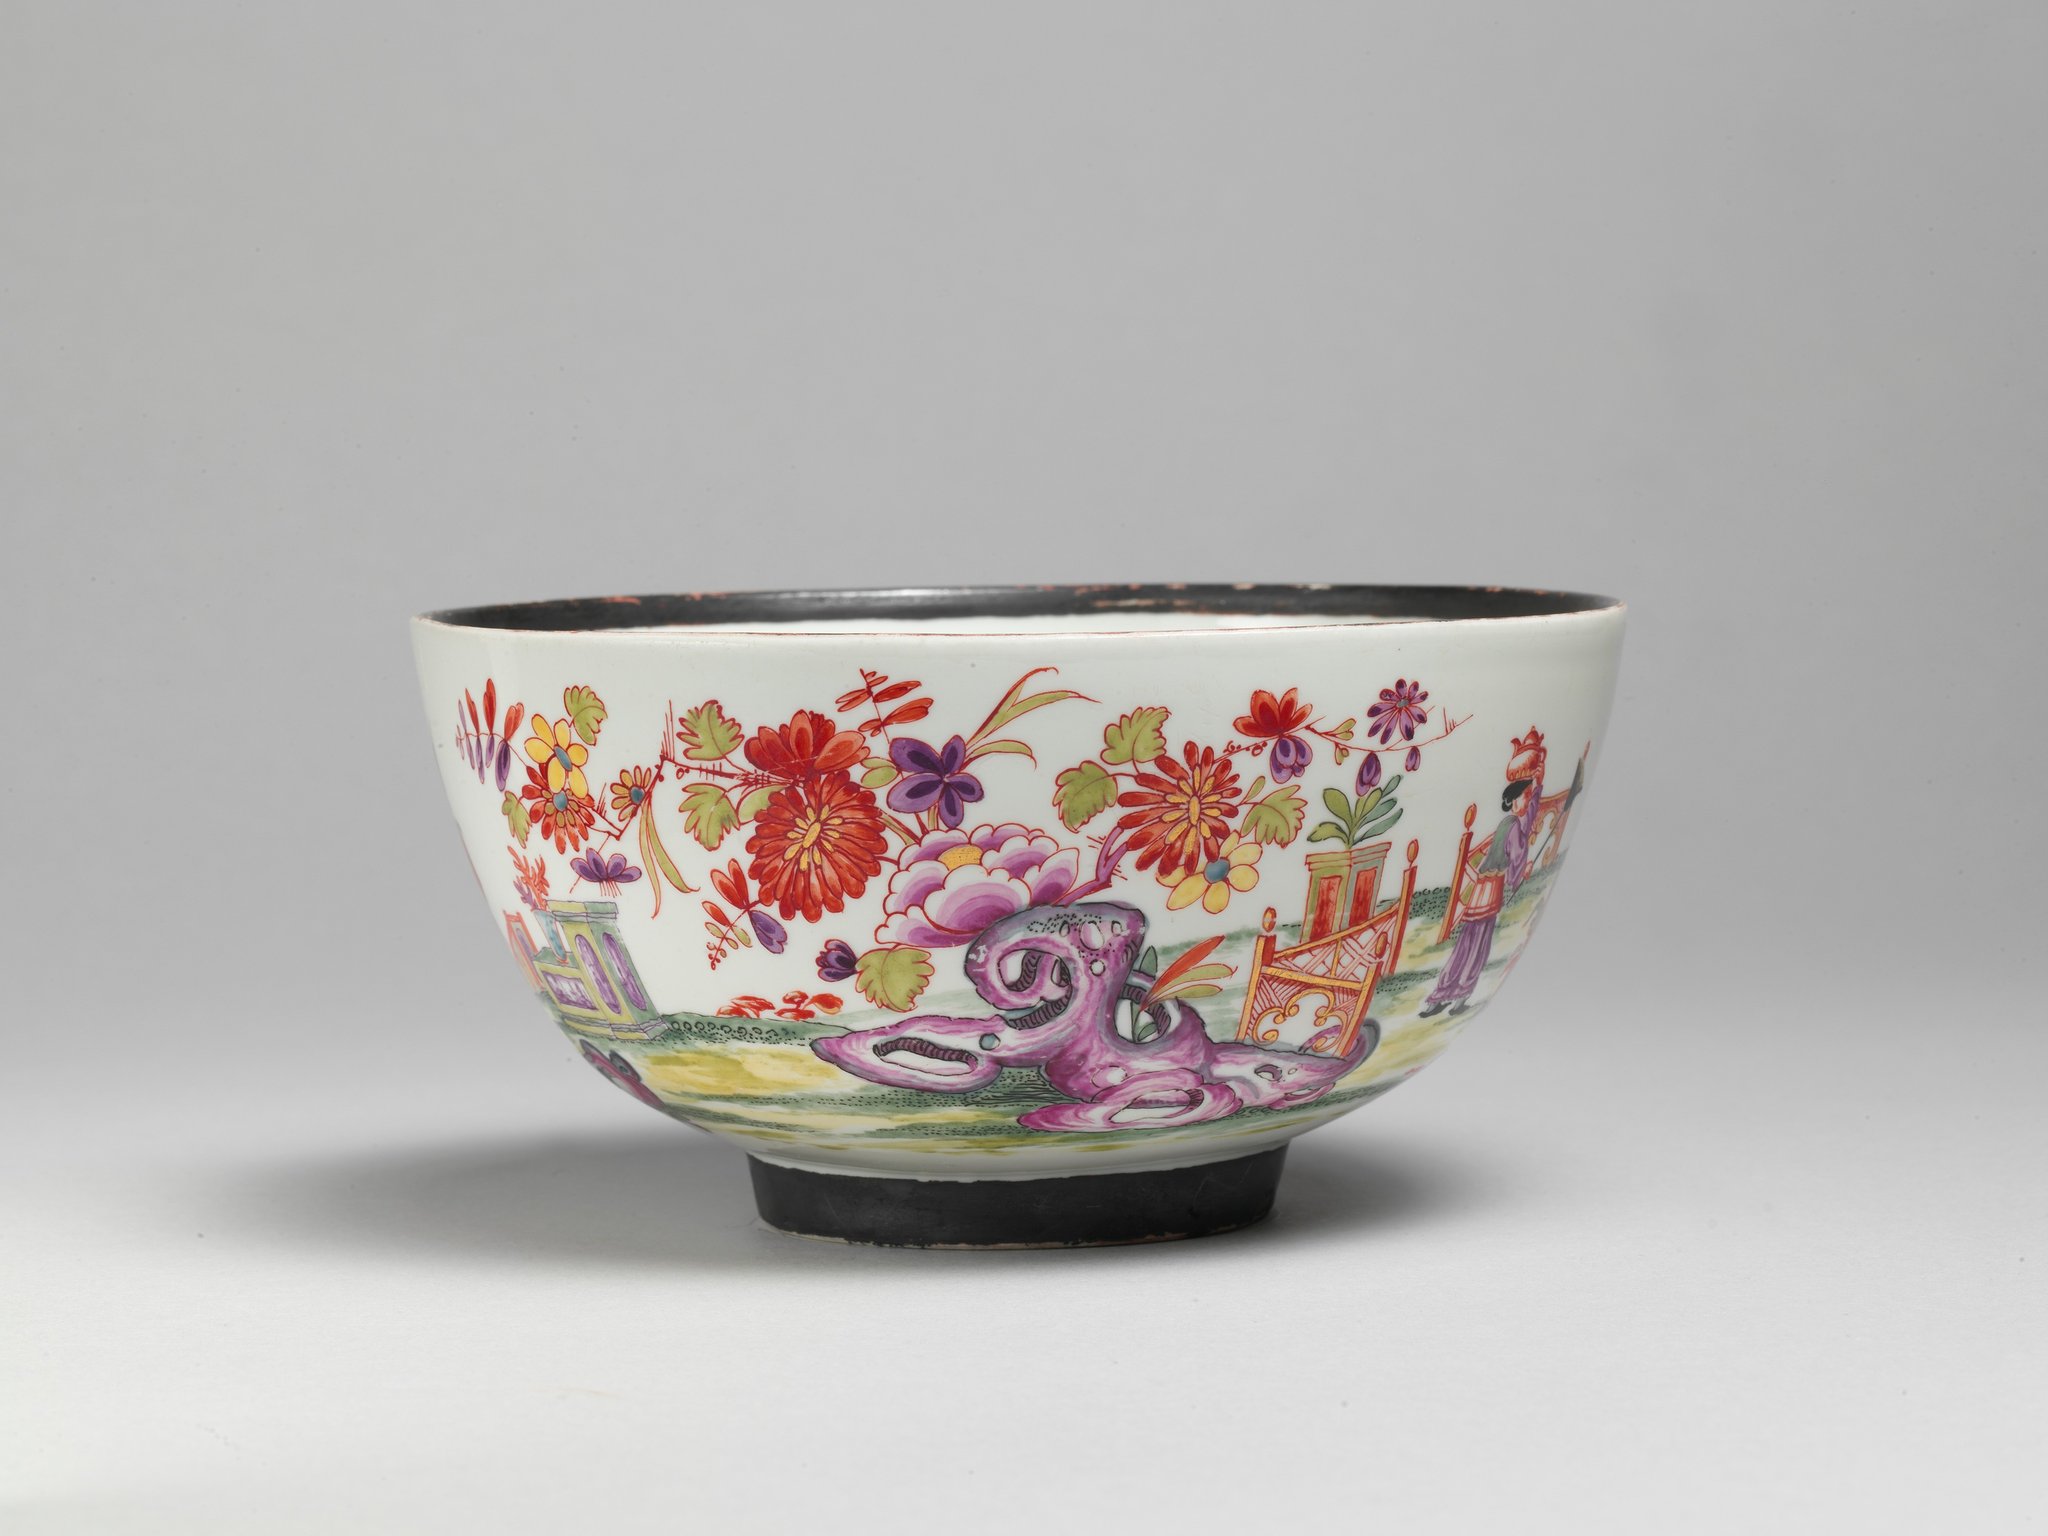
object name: bowl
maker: vienna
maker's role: manufactory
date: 1730-1735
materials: hard paste porcelain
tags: chinoiserie,men,flowers